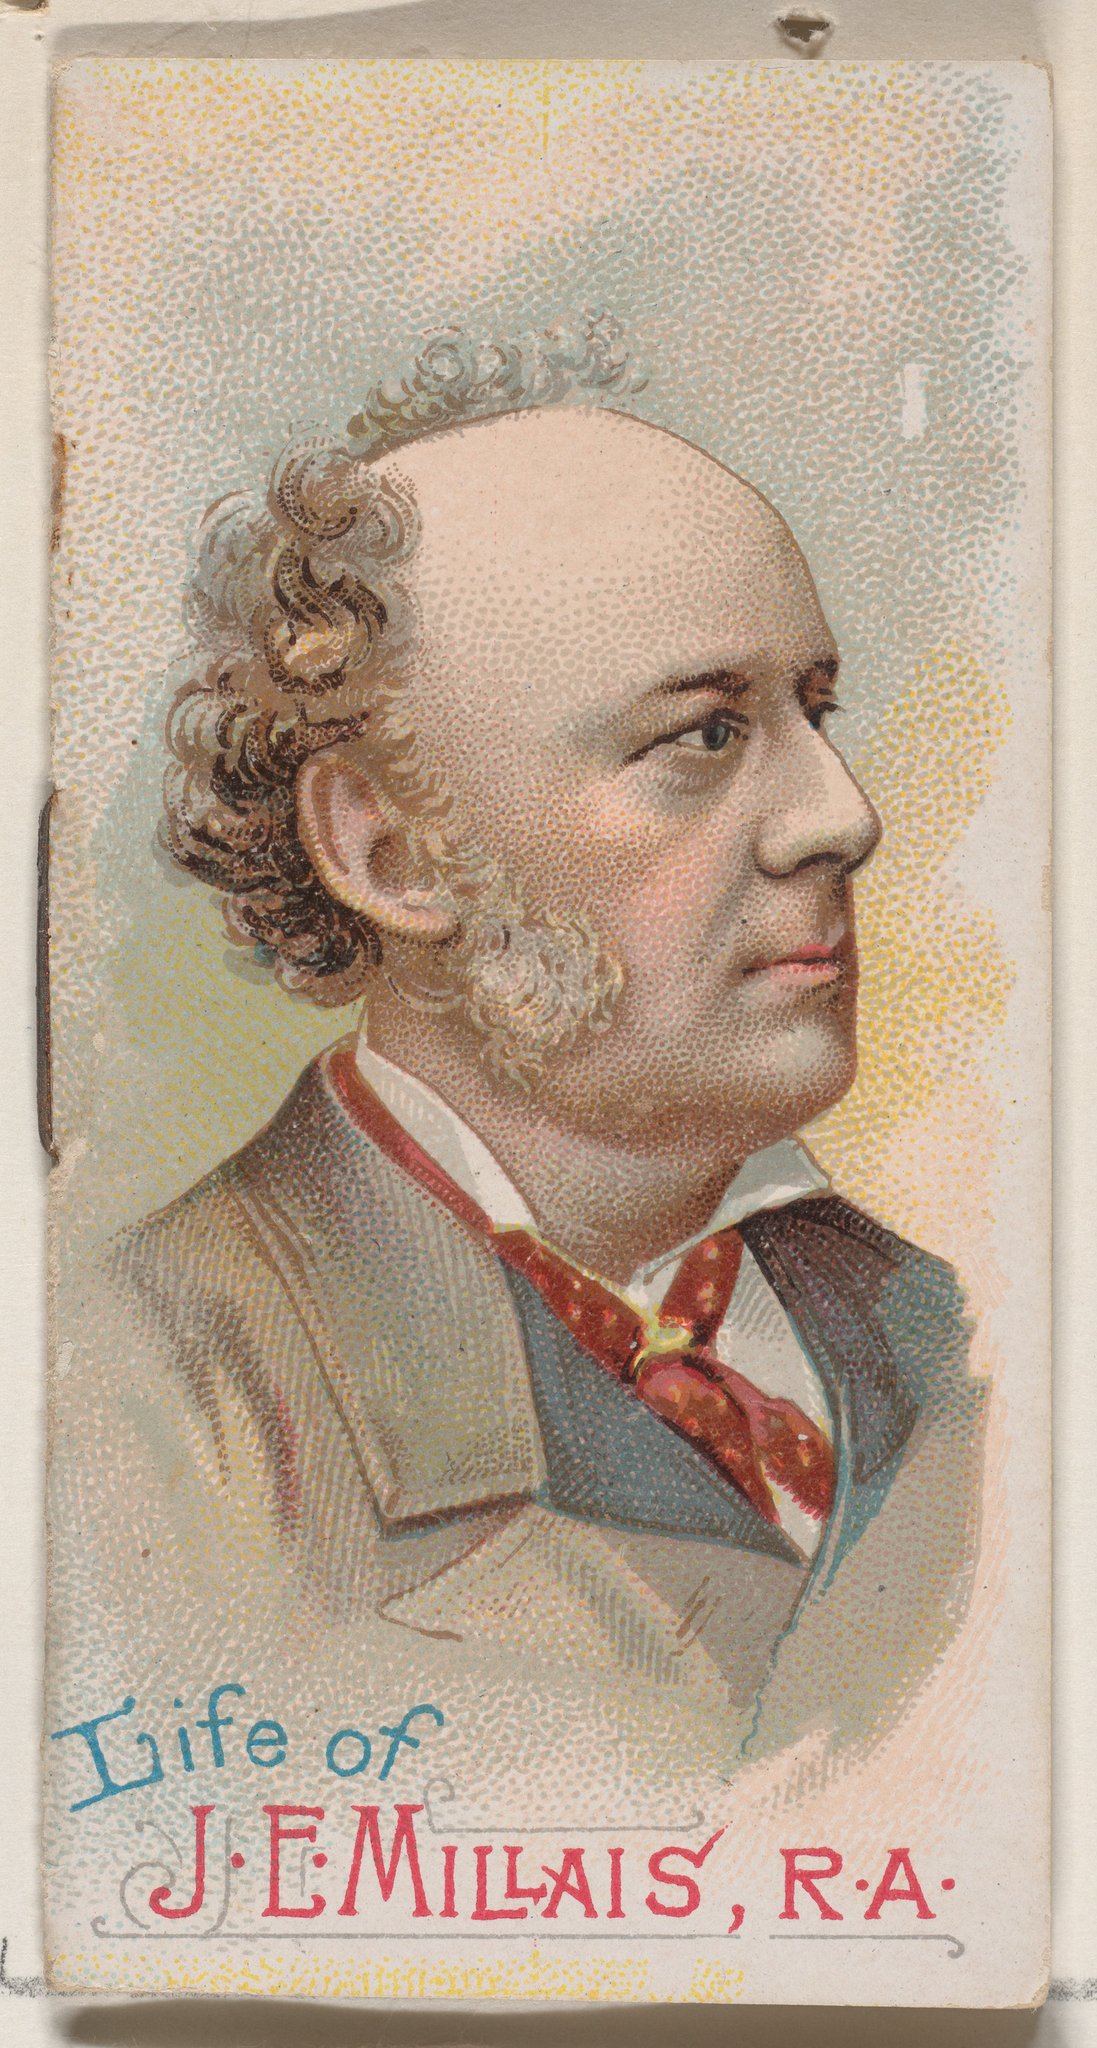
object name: print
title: Life of Sir John Everett Millais, R.A., from the Histories of Poor Boys and Famous People series of booklets (N79) for Duke brand cigarettes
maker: w. duke, sons & co.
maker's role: publisher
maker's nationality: american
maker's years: 1870-1920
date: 1888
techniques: color lithograph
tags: men,portraits